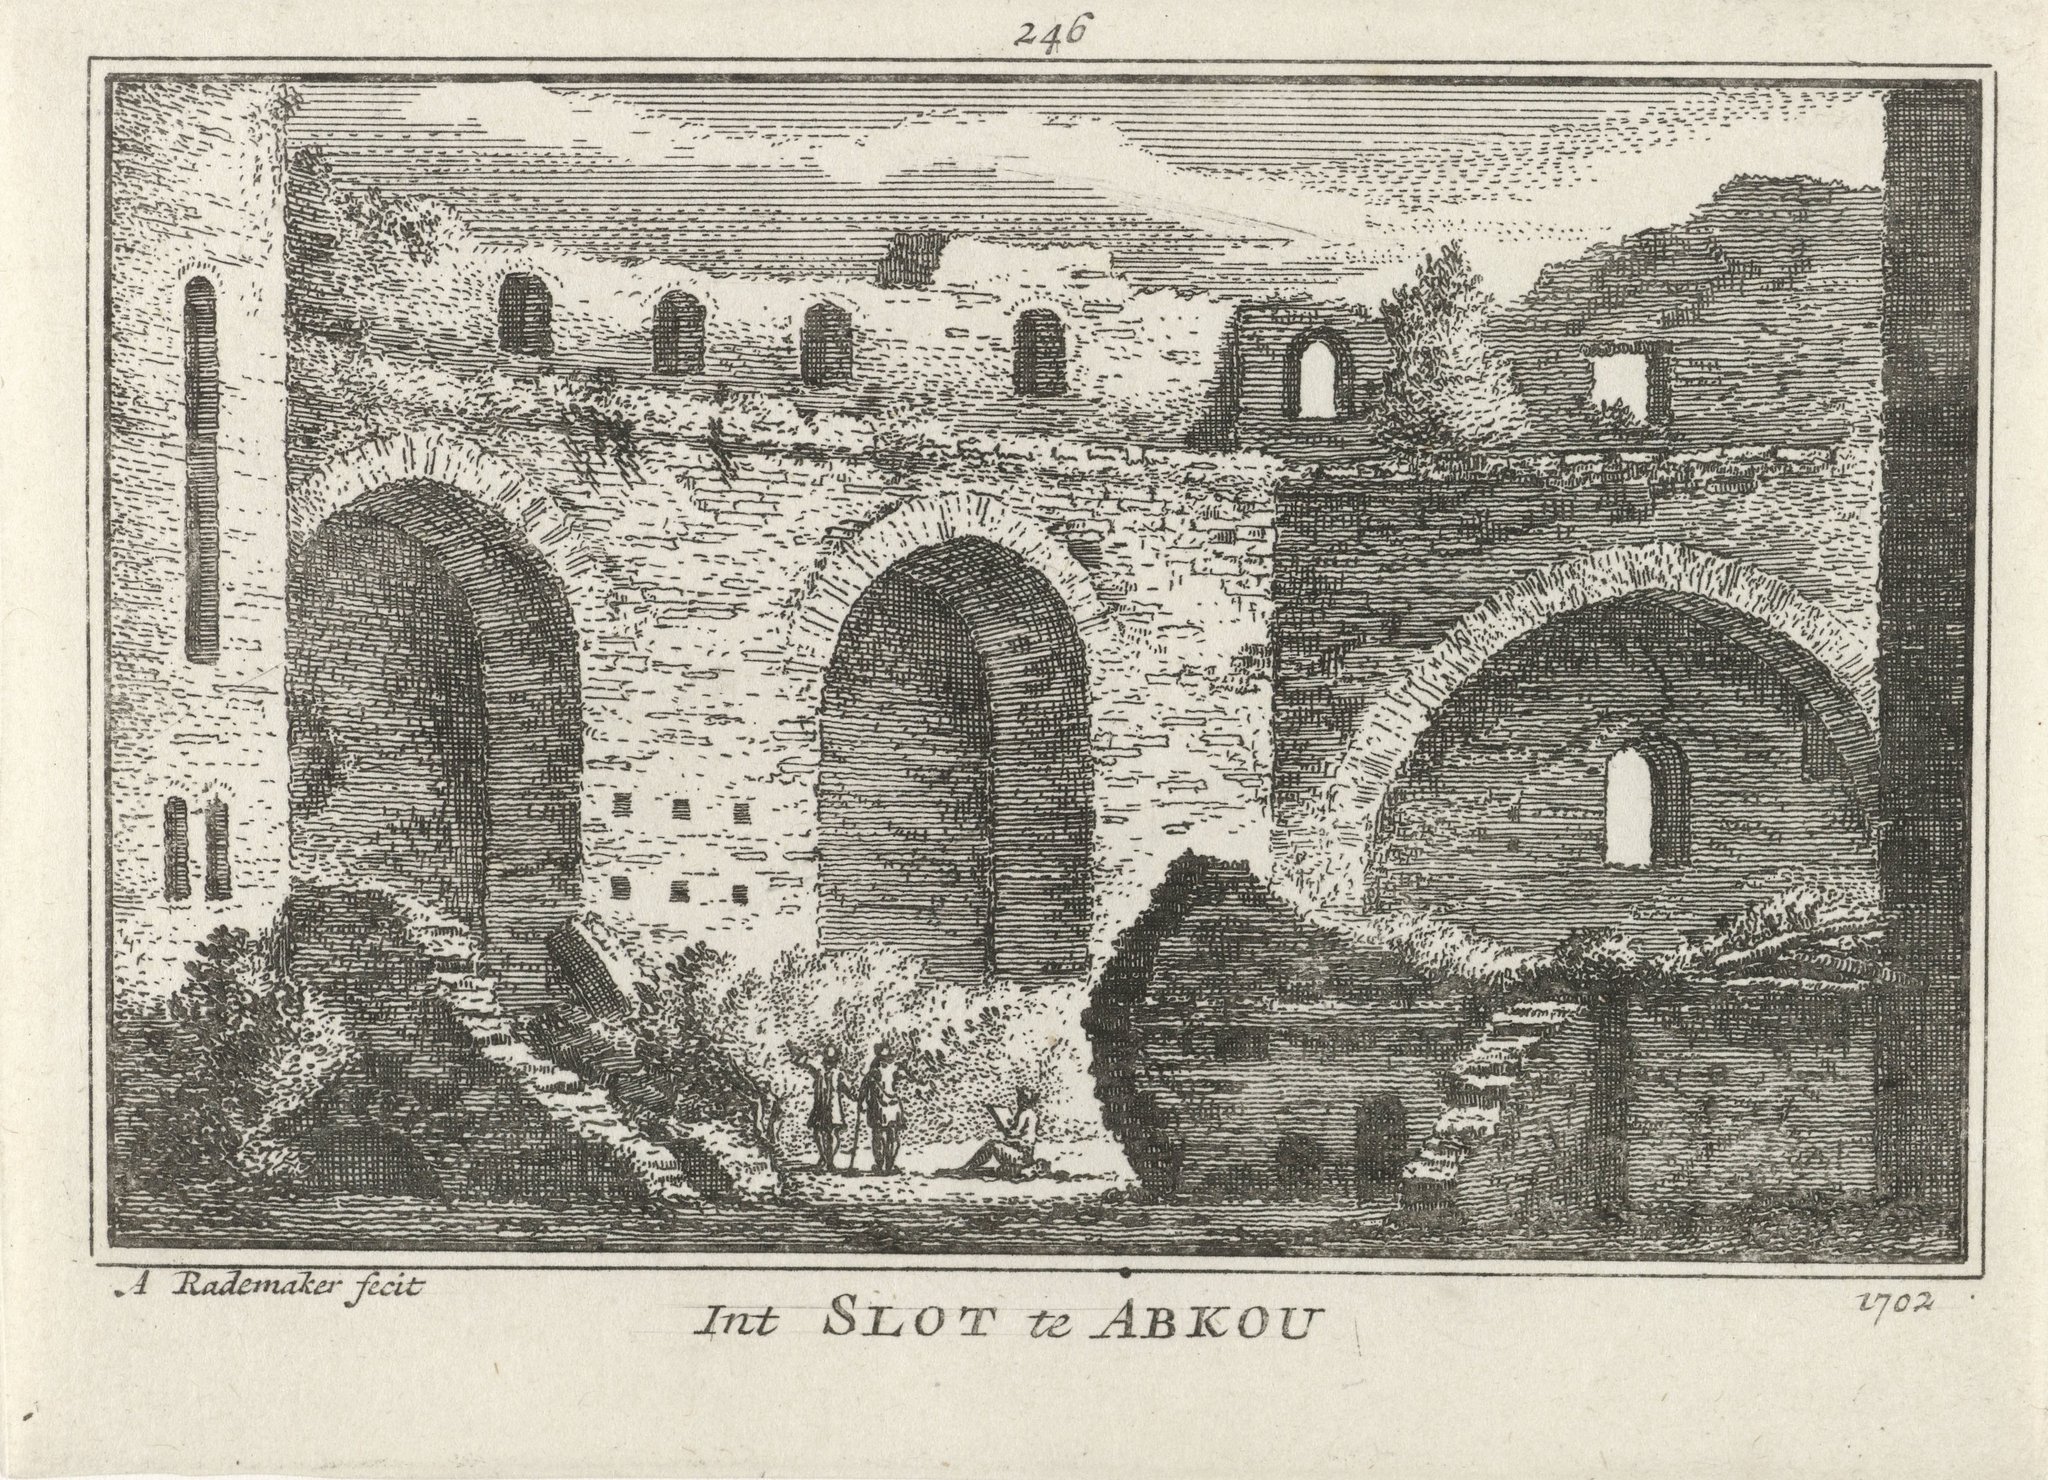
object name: print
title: Int Slot te Abkou 1702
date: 1727-1733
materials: paper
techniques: etching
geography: amsterdam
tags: draughtsman at work, ruin of a dwelling, house, castle, etc.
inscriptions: collector's mark: Lugt 2228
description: Illustratie uit: Abraham Rademaker, Matthaeus Brouërius van Niedek, Isaac Le Long, Kabinet van Nederlandsche en Kleefsche outheden en (...) voorname stads- en landgebouwen, Willem Barents en Antoni Schoonenburg: Amsterdam, 1727-1733, ill. nr. 246.